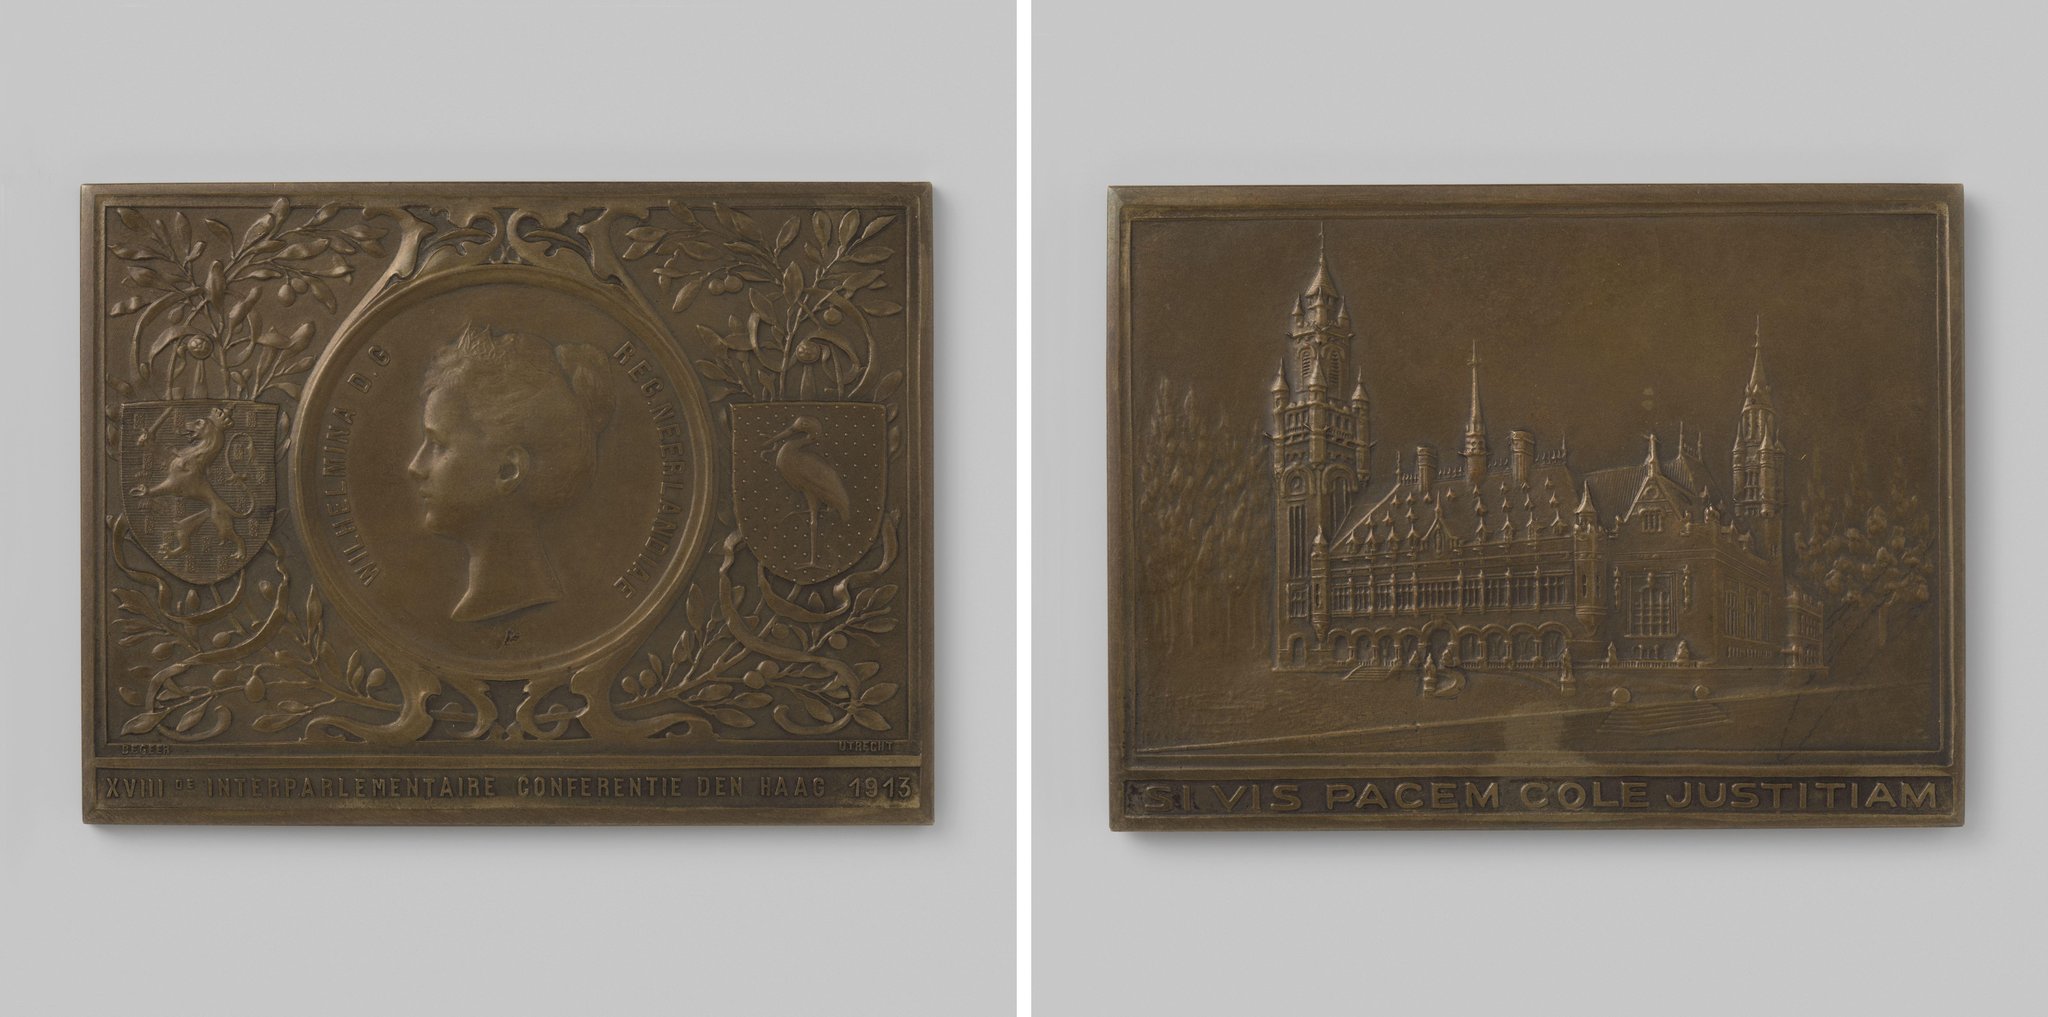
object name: plaque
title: XVIIIe Interparlementaire Vredesconferentie Den Haag, 1913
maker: jacob jan van goor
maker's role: medailleur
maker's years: 1874-1956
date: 1913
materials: bronze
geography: utrecht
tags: the hague, wilhelmina of the netherlands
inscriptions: circumscription: ‘WILHELMINA D.G REG.NEERLANDIAE’, caption: ‘SI VIS PACEM COLE JUSTITIAM’, signature: ‘BEGEER UTRECHT’, caption: ‘XVIIIDE INTERPARLEMENTAIRE CONFERENTIE DEN HAAG 1913’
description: Rechthoekige bronzen plaquette. Voorzijde: wapenschilden van Nederland en Den Haag omringd door oranjetakken. Daartussen borstbeeld vrouw met opgestoken haar in profiel naar links (Koningin Wilhelmina) met omschrift in cirkel. Met signatuur en onderschrift. Keerzijde: gezicht op gebouw (Vredespaleis te Den Haag) tussen bomen met onderschrift. In originele doos.